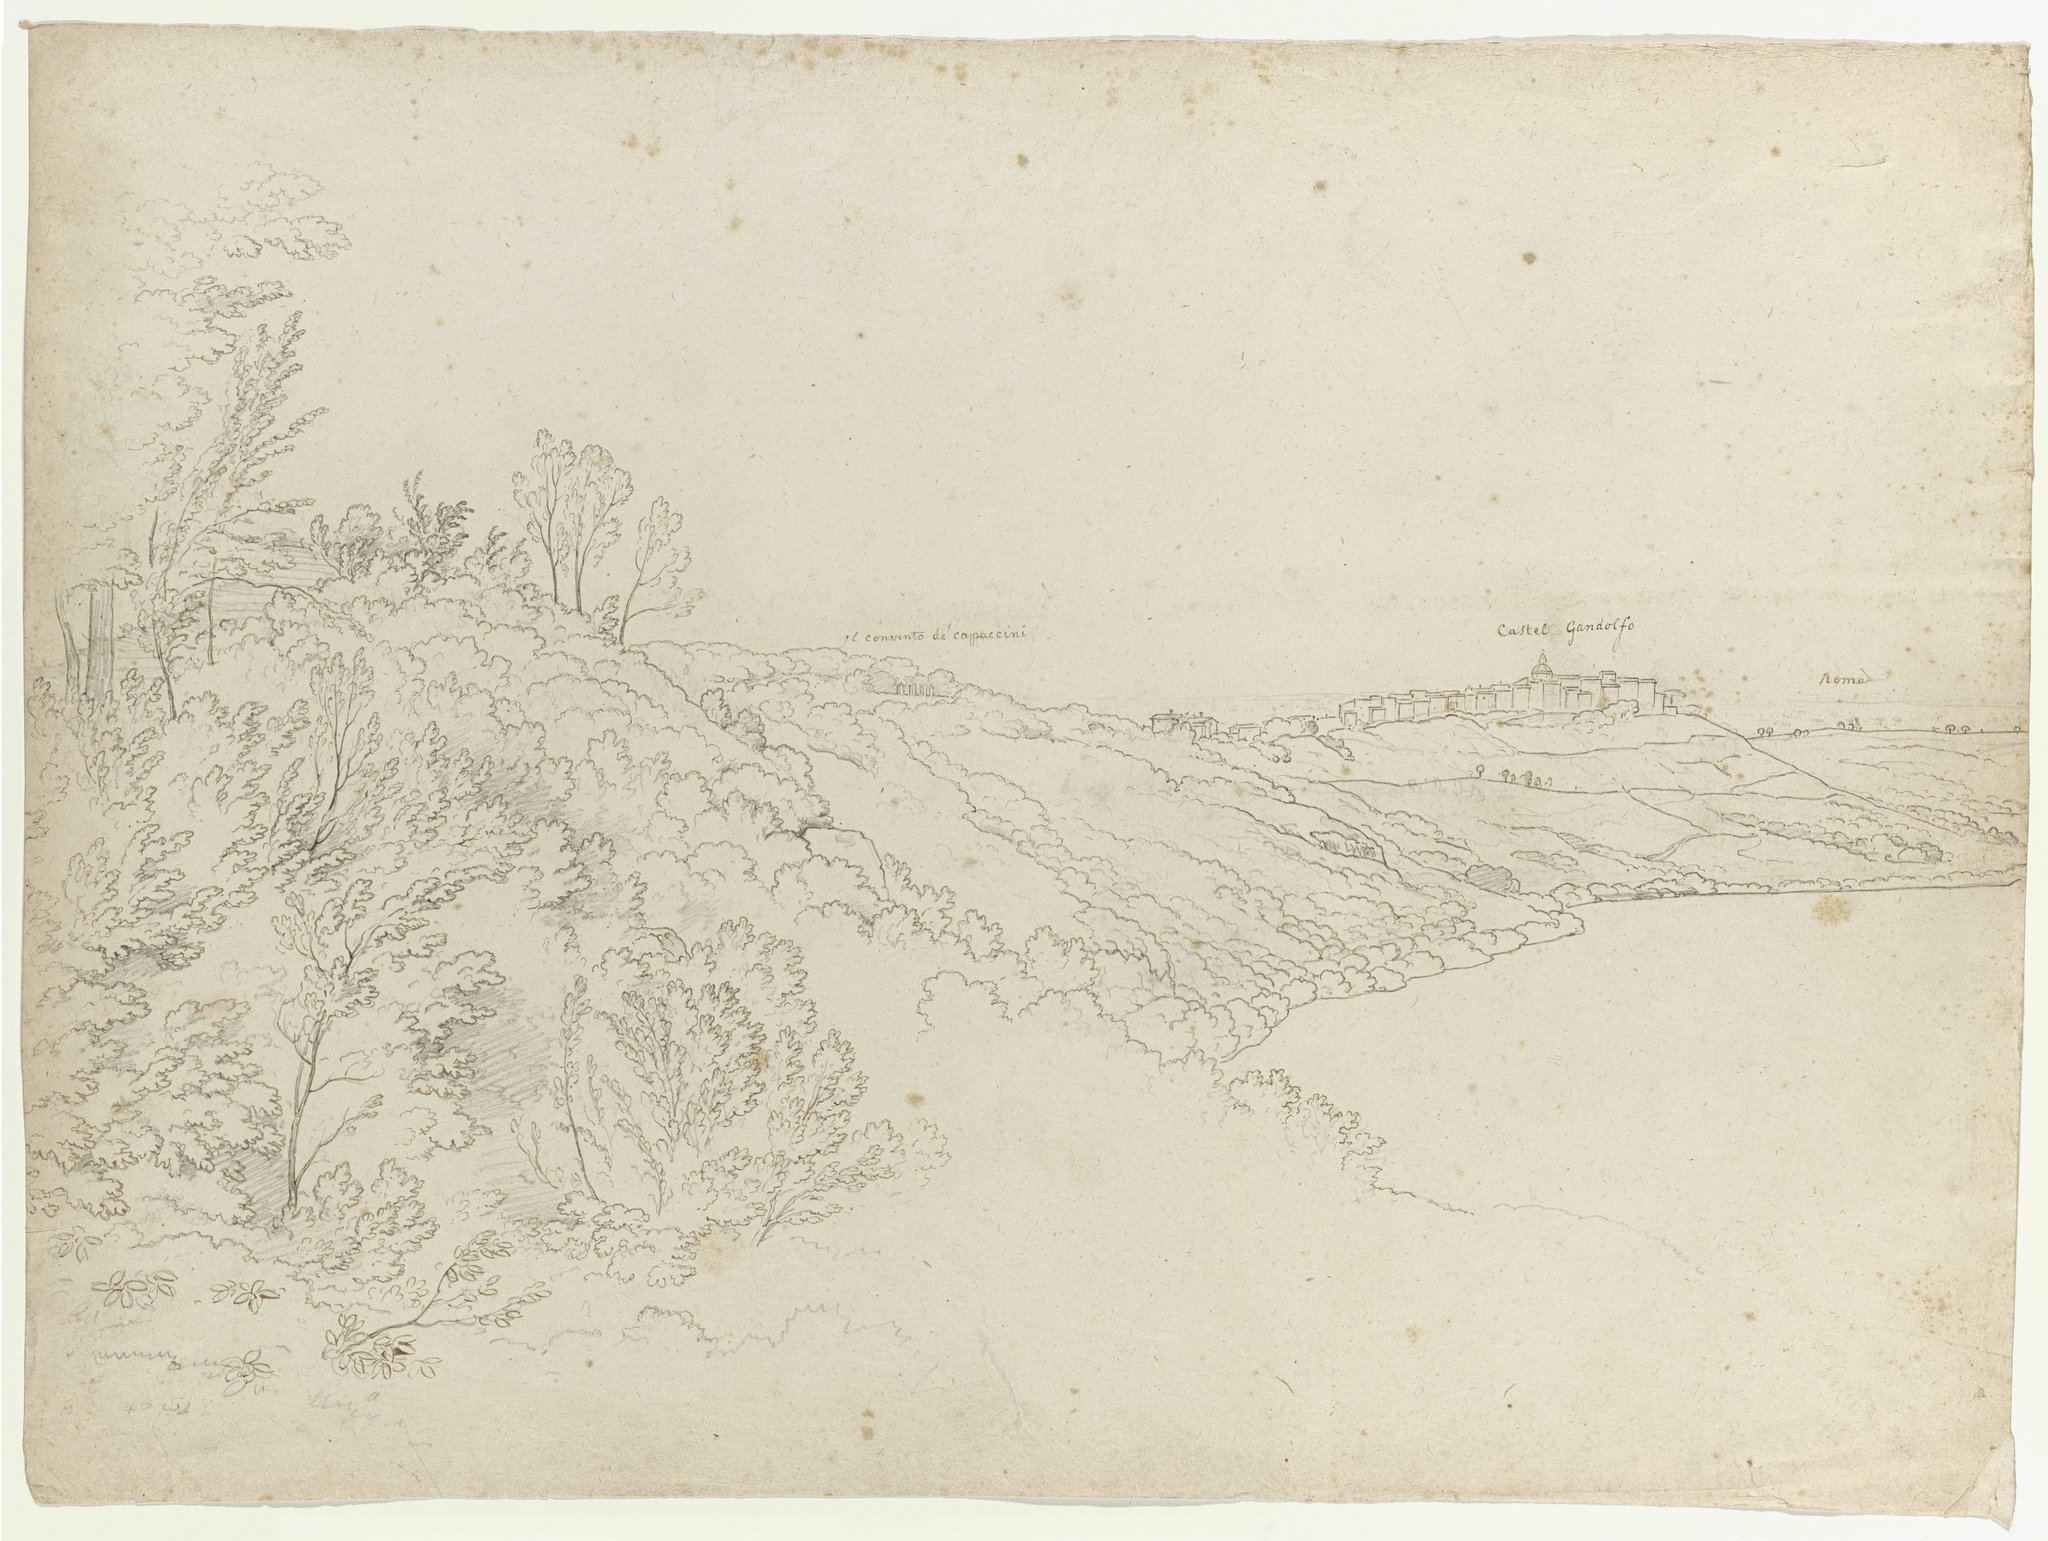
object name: drawing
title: Gezicht ten zuiden van Rome, met Castel Gandolfo aan de overkant van het Meer van Albano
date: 1786-1857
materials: chalk, ink, paper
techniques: pen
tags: landscapes in the temperate zone, lake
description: Tekening uit een groep tekeningen van landschappen en stadsgezichten in Italië (Rome, Tivoli, Civita Castellana en Pozzuoli).